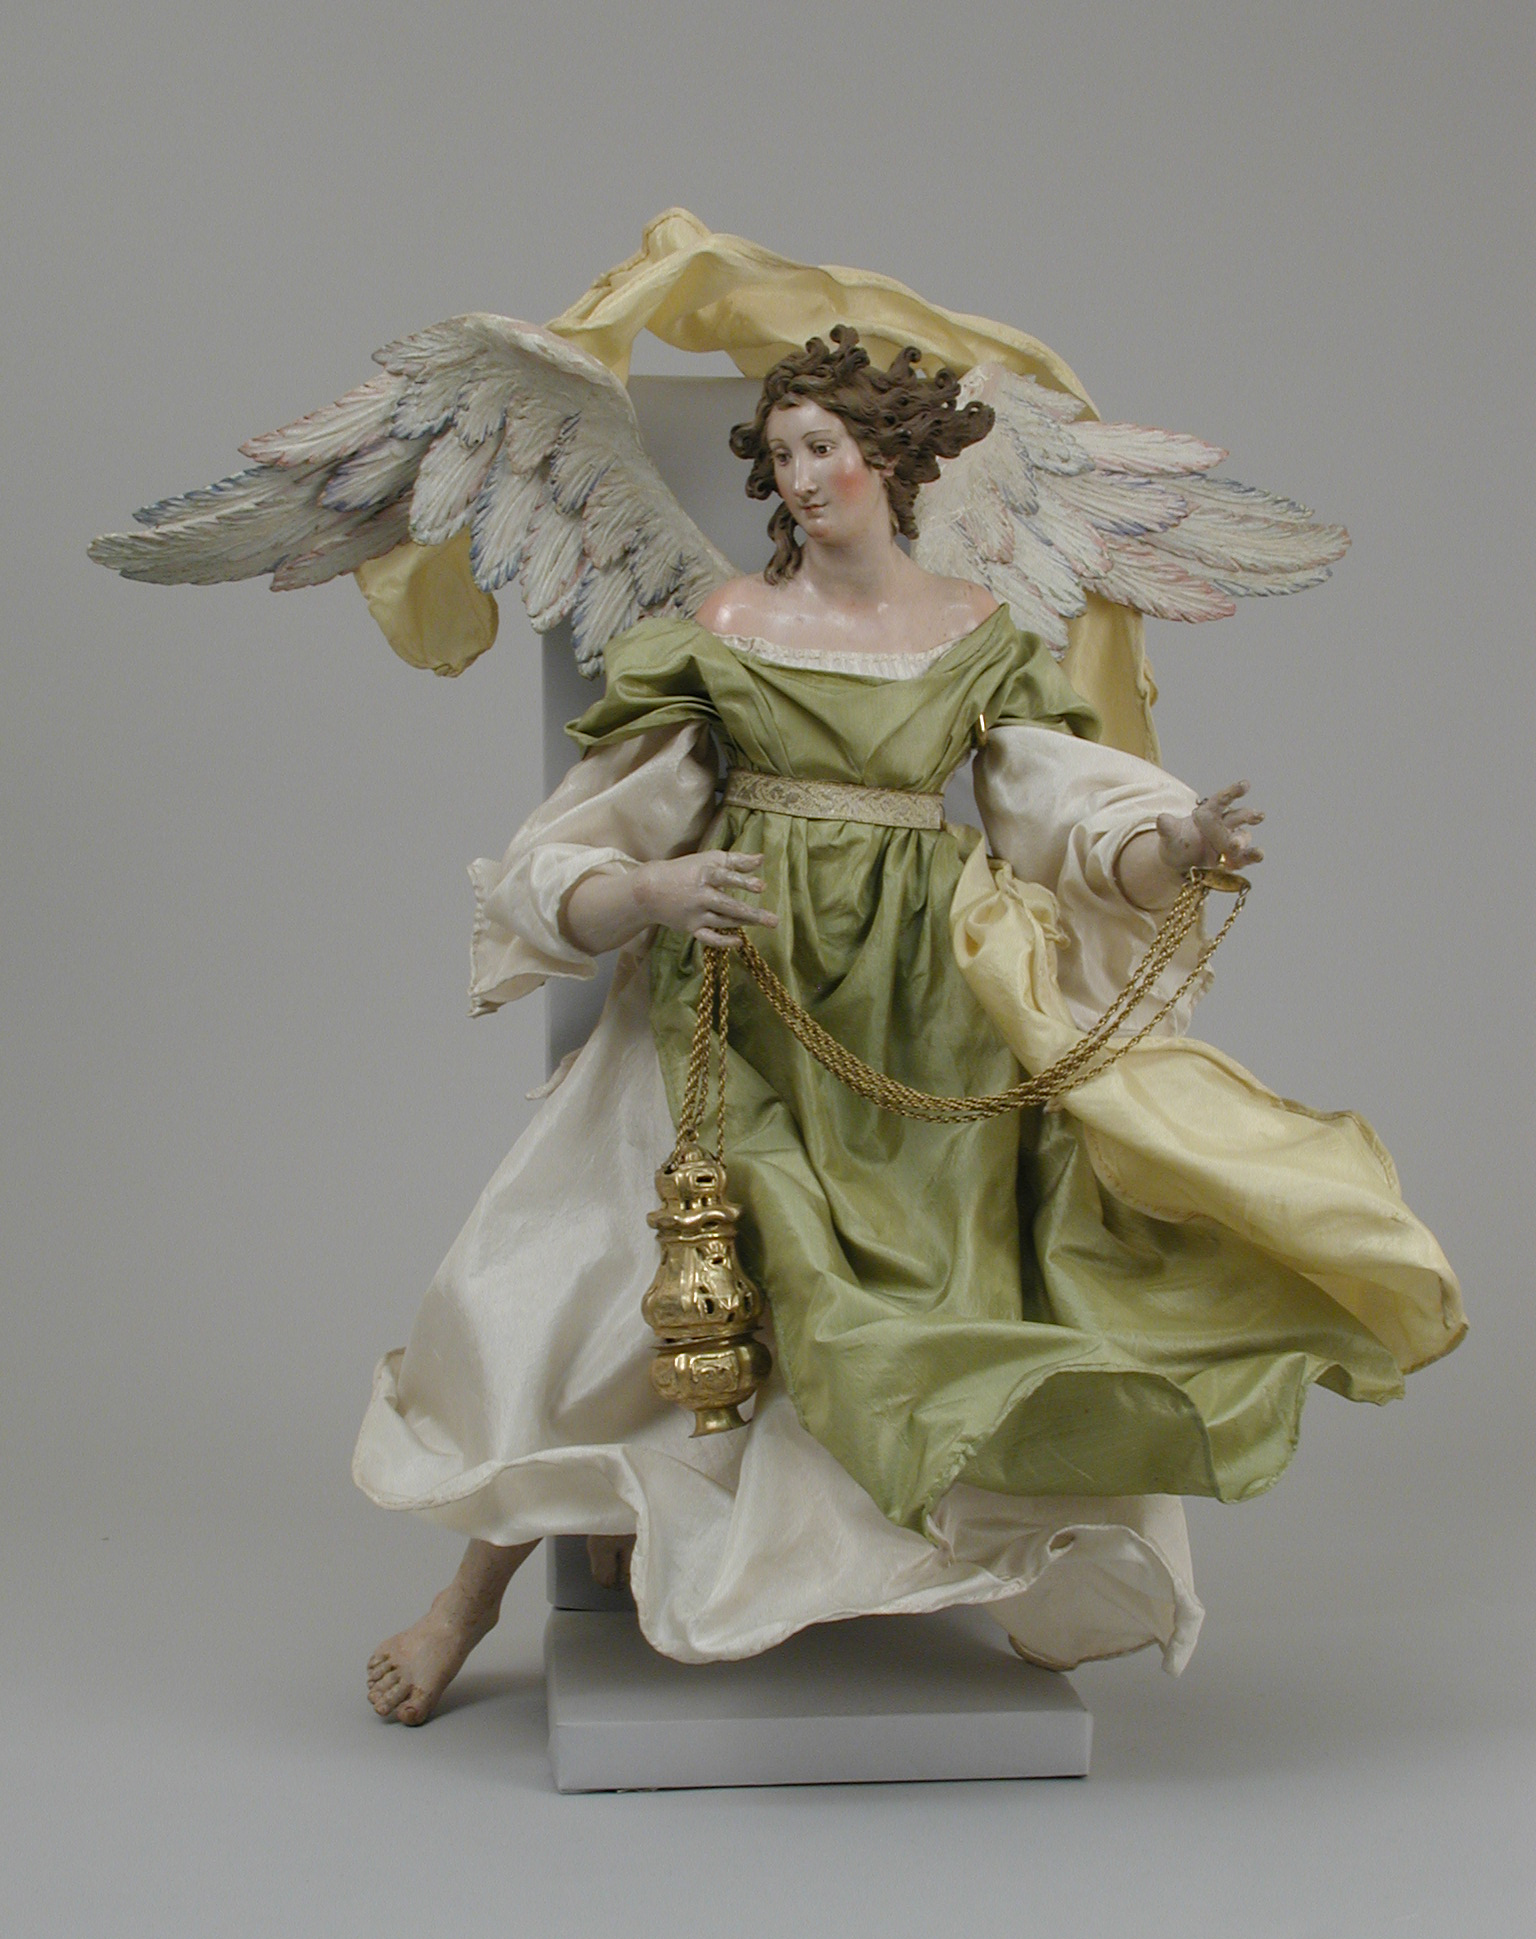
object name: crèche figure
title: Angel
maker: salvatore di franco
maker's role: maker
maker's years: 1700-1799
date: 1751-1800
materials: silk, silver gilt, terracotta, fiber, metal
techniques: polychrome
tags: angels